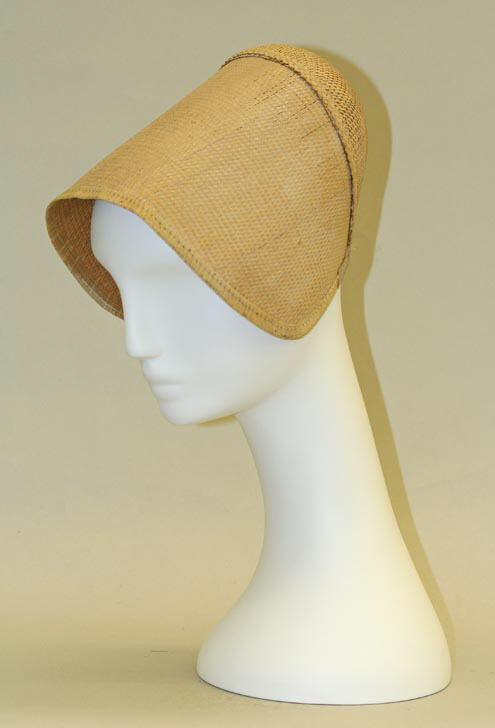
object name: bonnet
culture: american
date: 1800-1875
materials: fiber